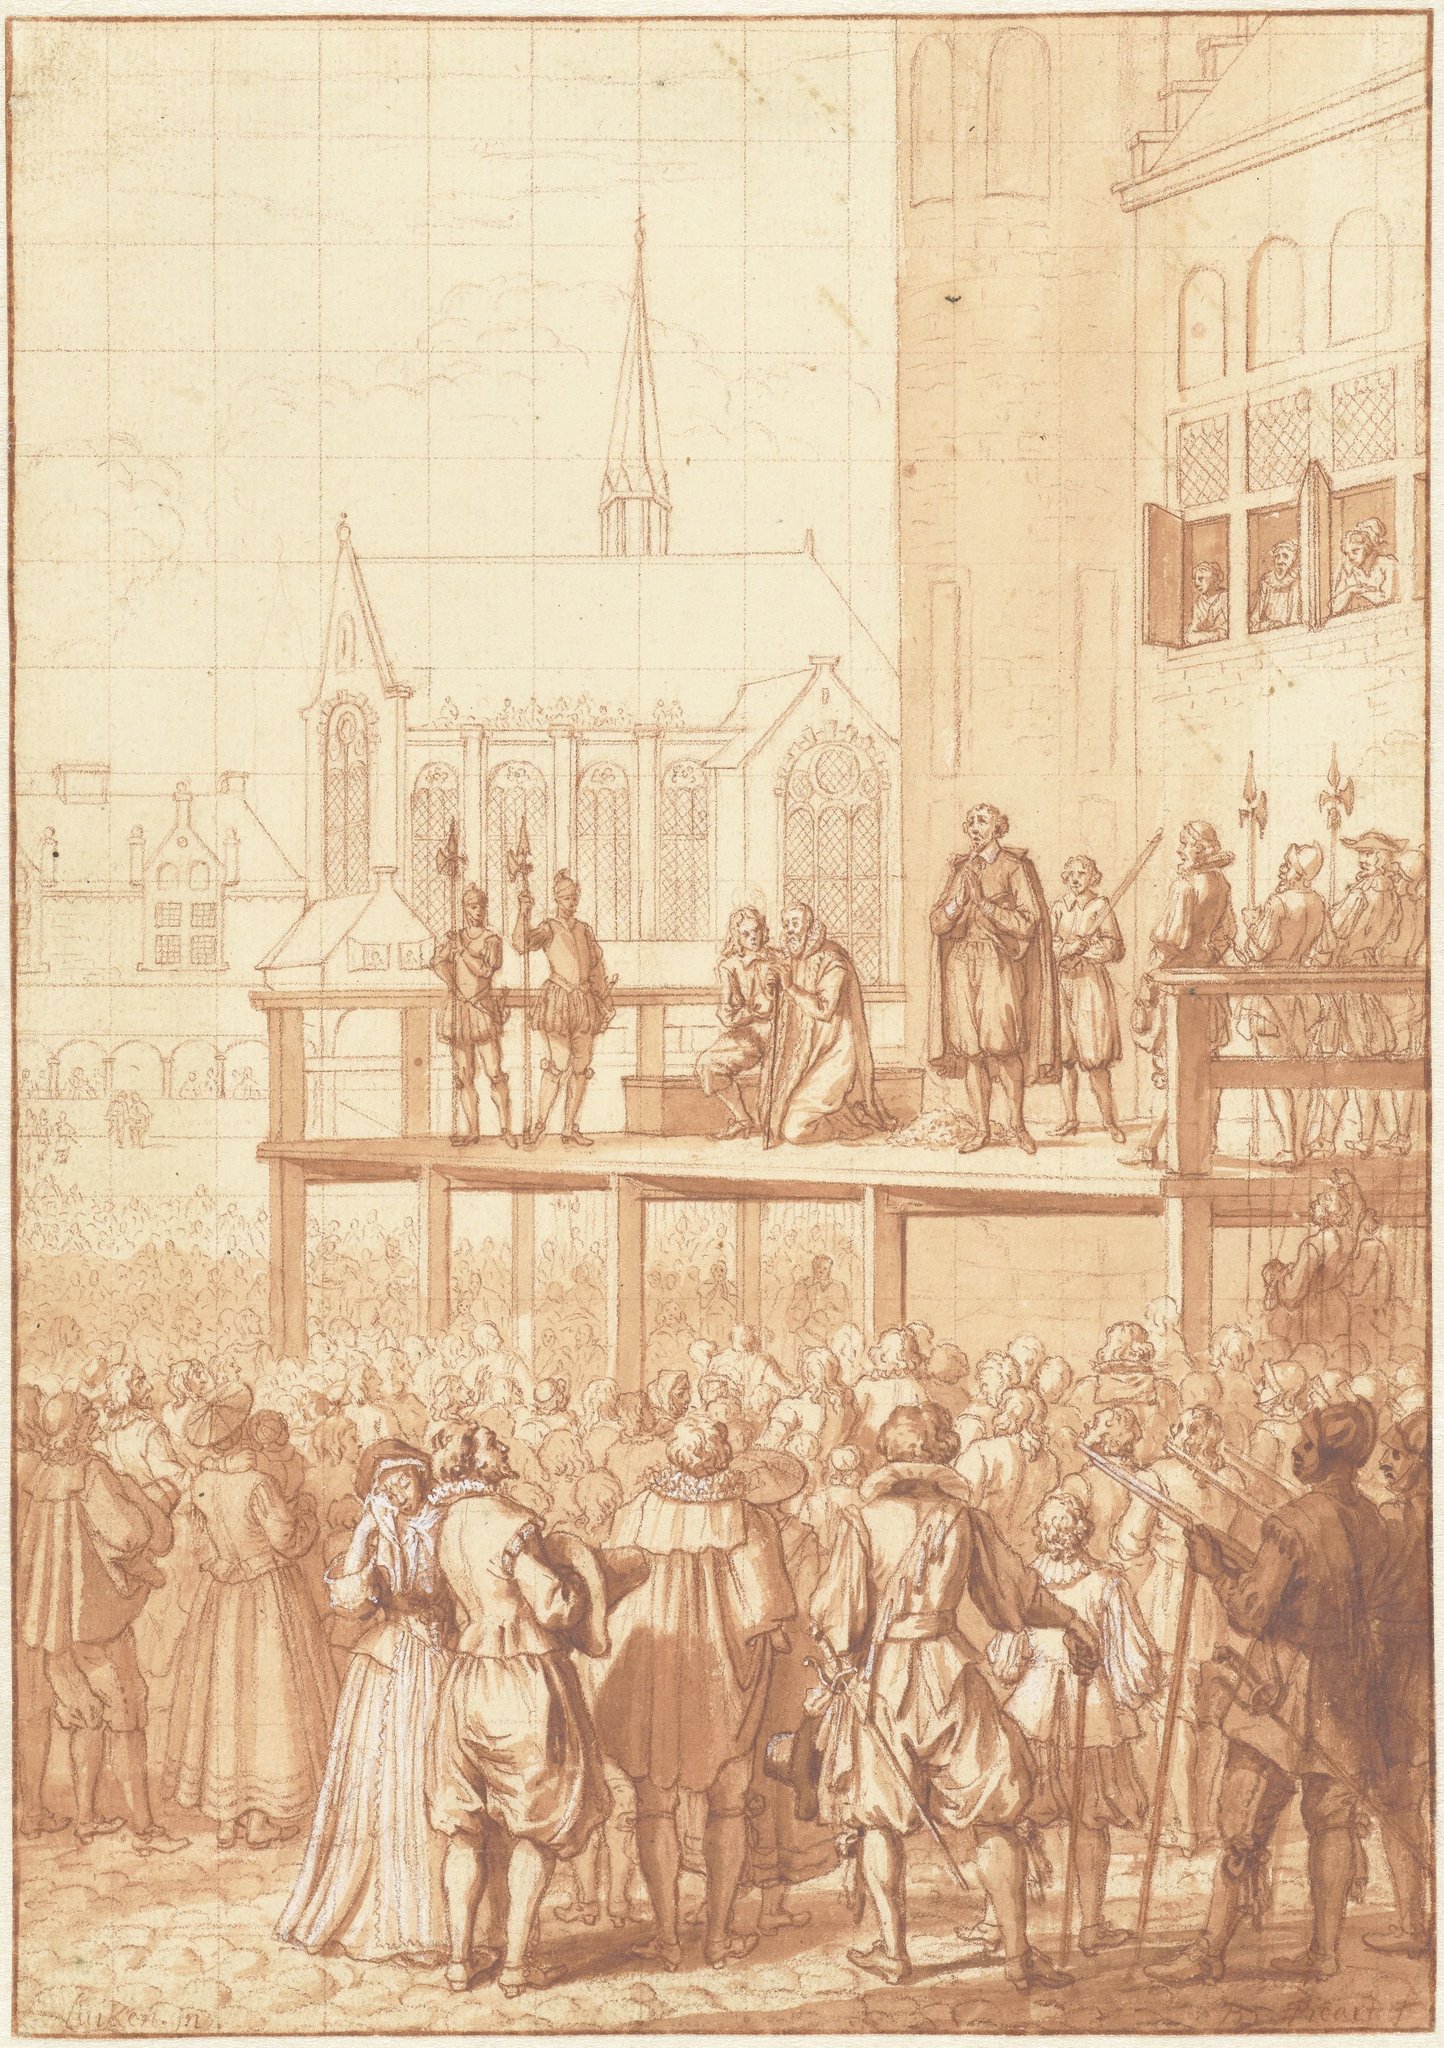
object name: design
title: Johan van Oldenbarnevelt knielt voor zijn onthoofding, 1619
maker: bernard picart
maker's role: draughtsman, print maker, publisher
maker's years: 1673-1733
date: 1728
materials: chalk, paint, paper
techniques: brush, drawing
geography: northern netherlands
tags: johan van oldenbarnevelt, historical persons, on the scaffold or place of execution, violent death by beheading, historical events and situations, the hague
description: Ontwerptekening voor illustratie in: J. le Clerc, Geschiedenissen der Vereenigde Nederlanden, sedert den aanvang van die Republyk tot op den Vrede van Utrecht in 't jaar 1713 en het Tractaat van Barriere in 't jaar 1715 gesloten, Z. Chatelain, Amsterdam 1730, 3 delen, dl. II, p. 202.